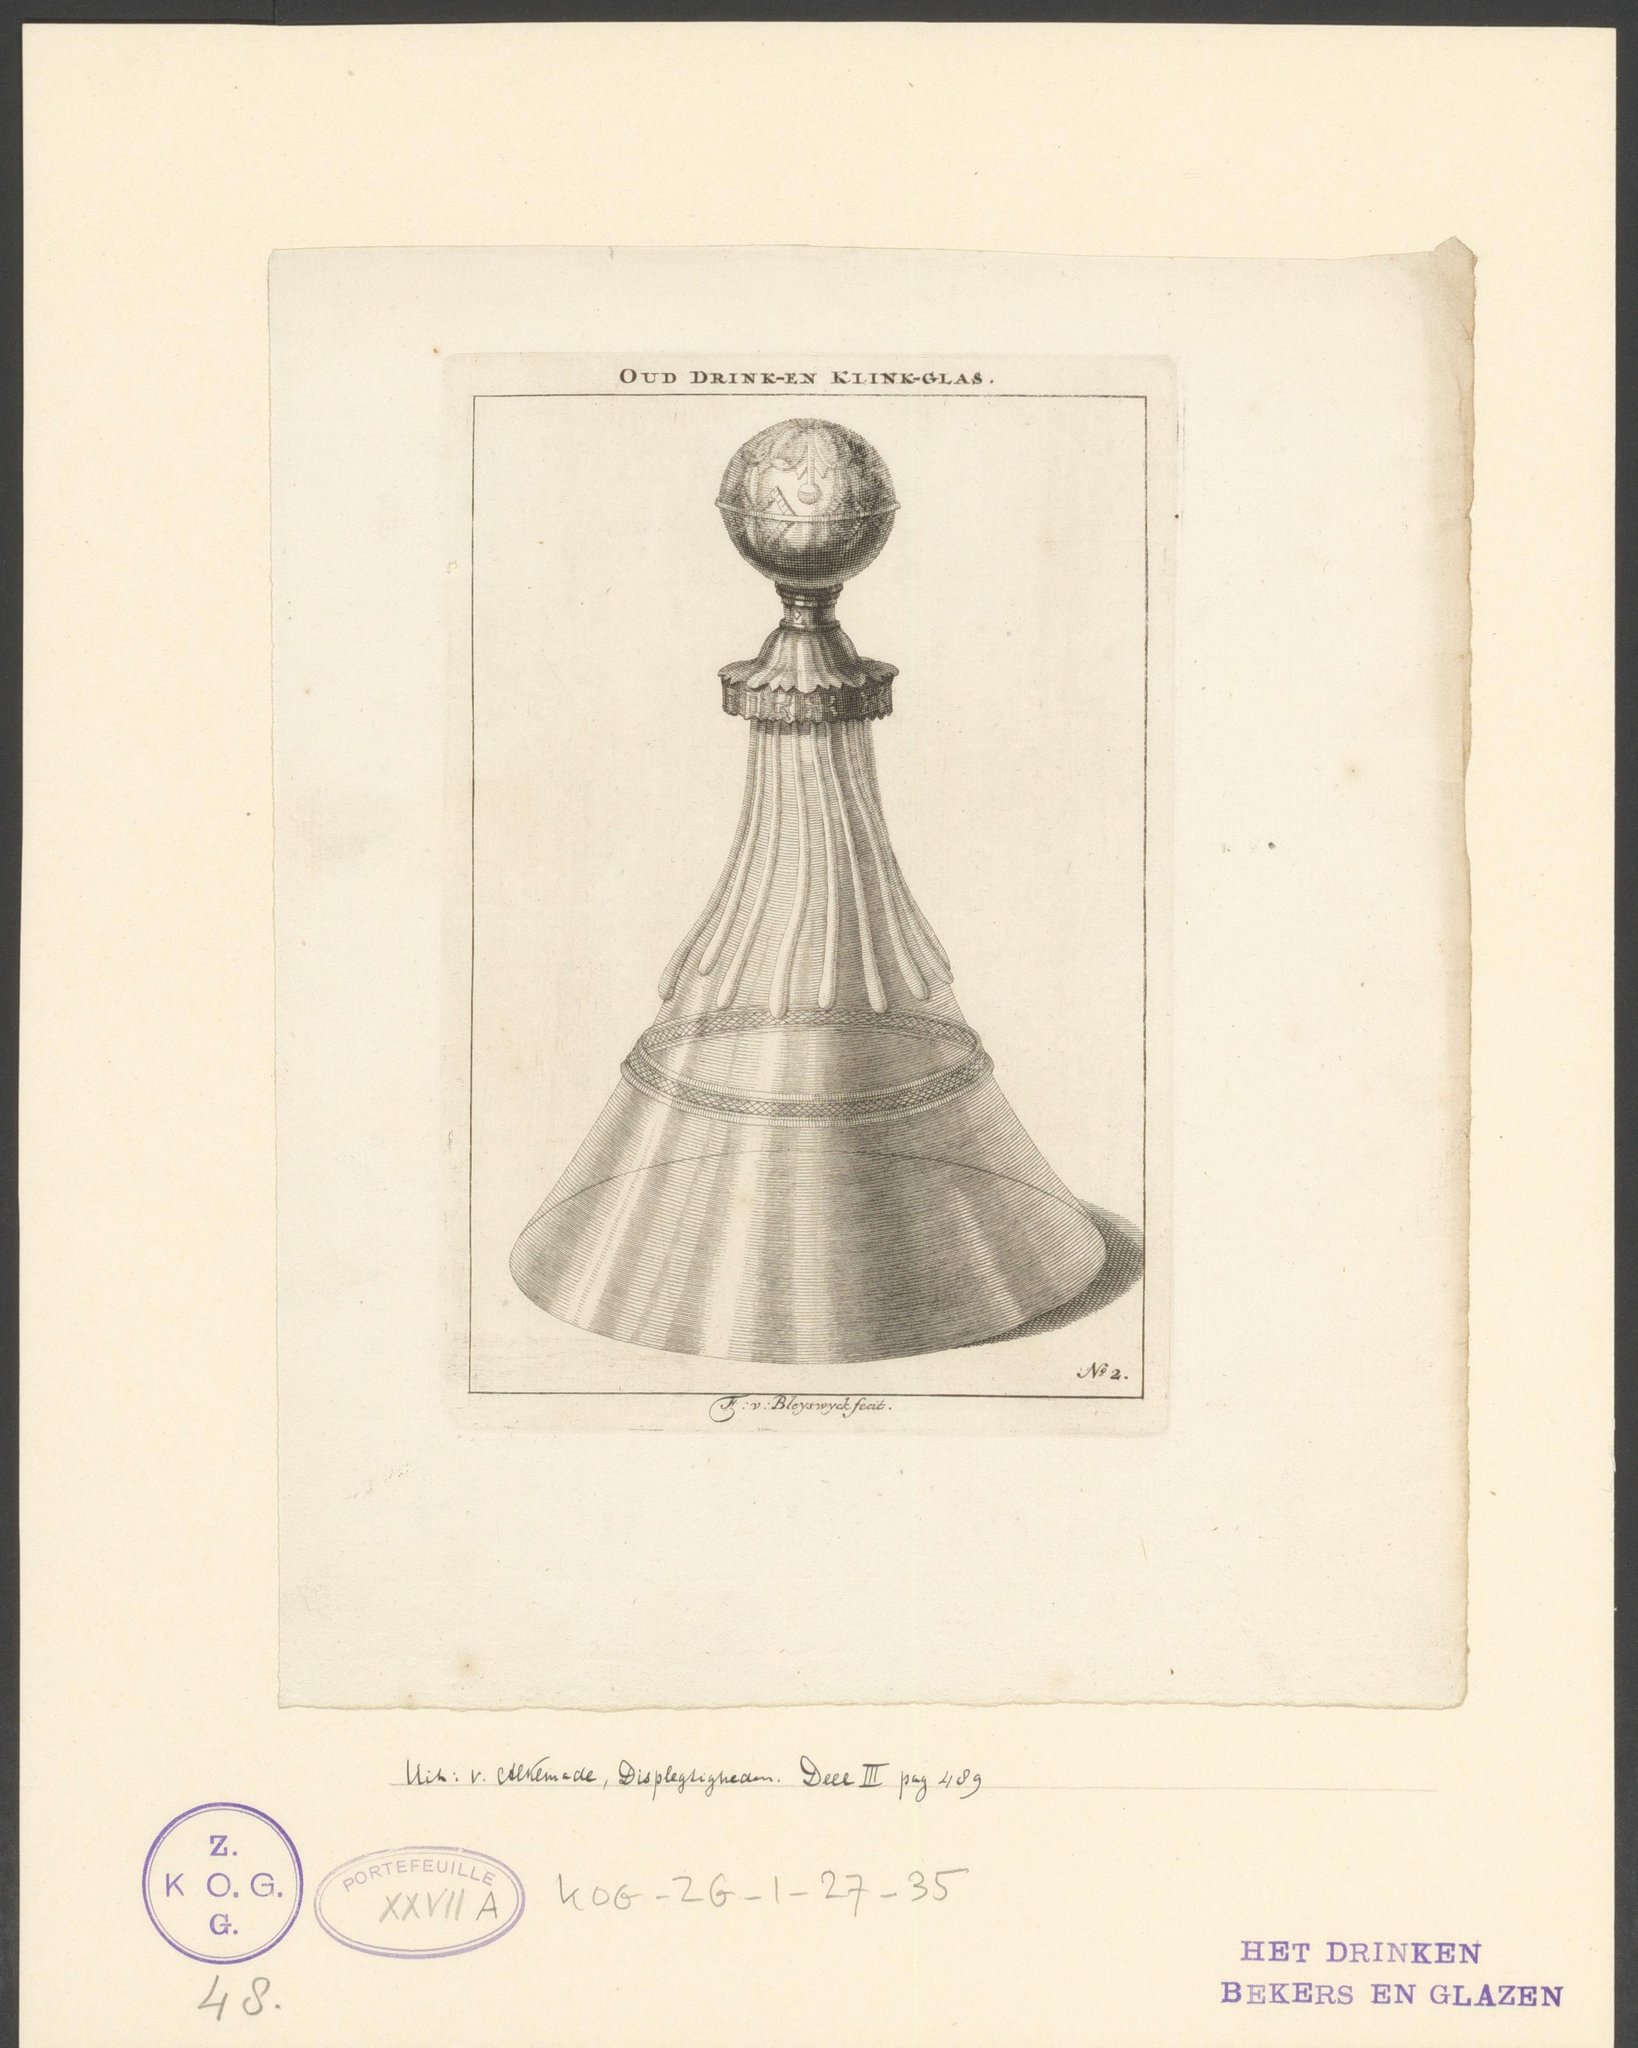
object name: print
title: Oud drink- en klink-glas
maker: françois van bleyswijck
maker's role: draughtsman, print maker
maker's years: 1671-1746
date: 1735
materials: paper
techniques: etching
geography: netherlands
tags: glass, rummer, alcoholic drinks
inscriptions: collector's mark: Lugt 1641, collector's mark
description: Gebruikt als illustratie in: Cornelis van Alkemade en Pieter van der Schelling, Nederlands displegtigheden. Rotterdam: Philippus Losel, 3 dln. 1732-1735, dl. III (1735), t.o. p. 489.